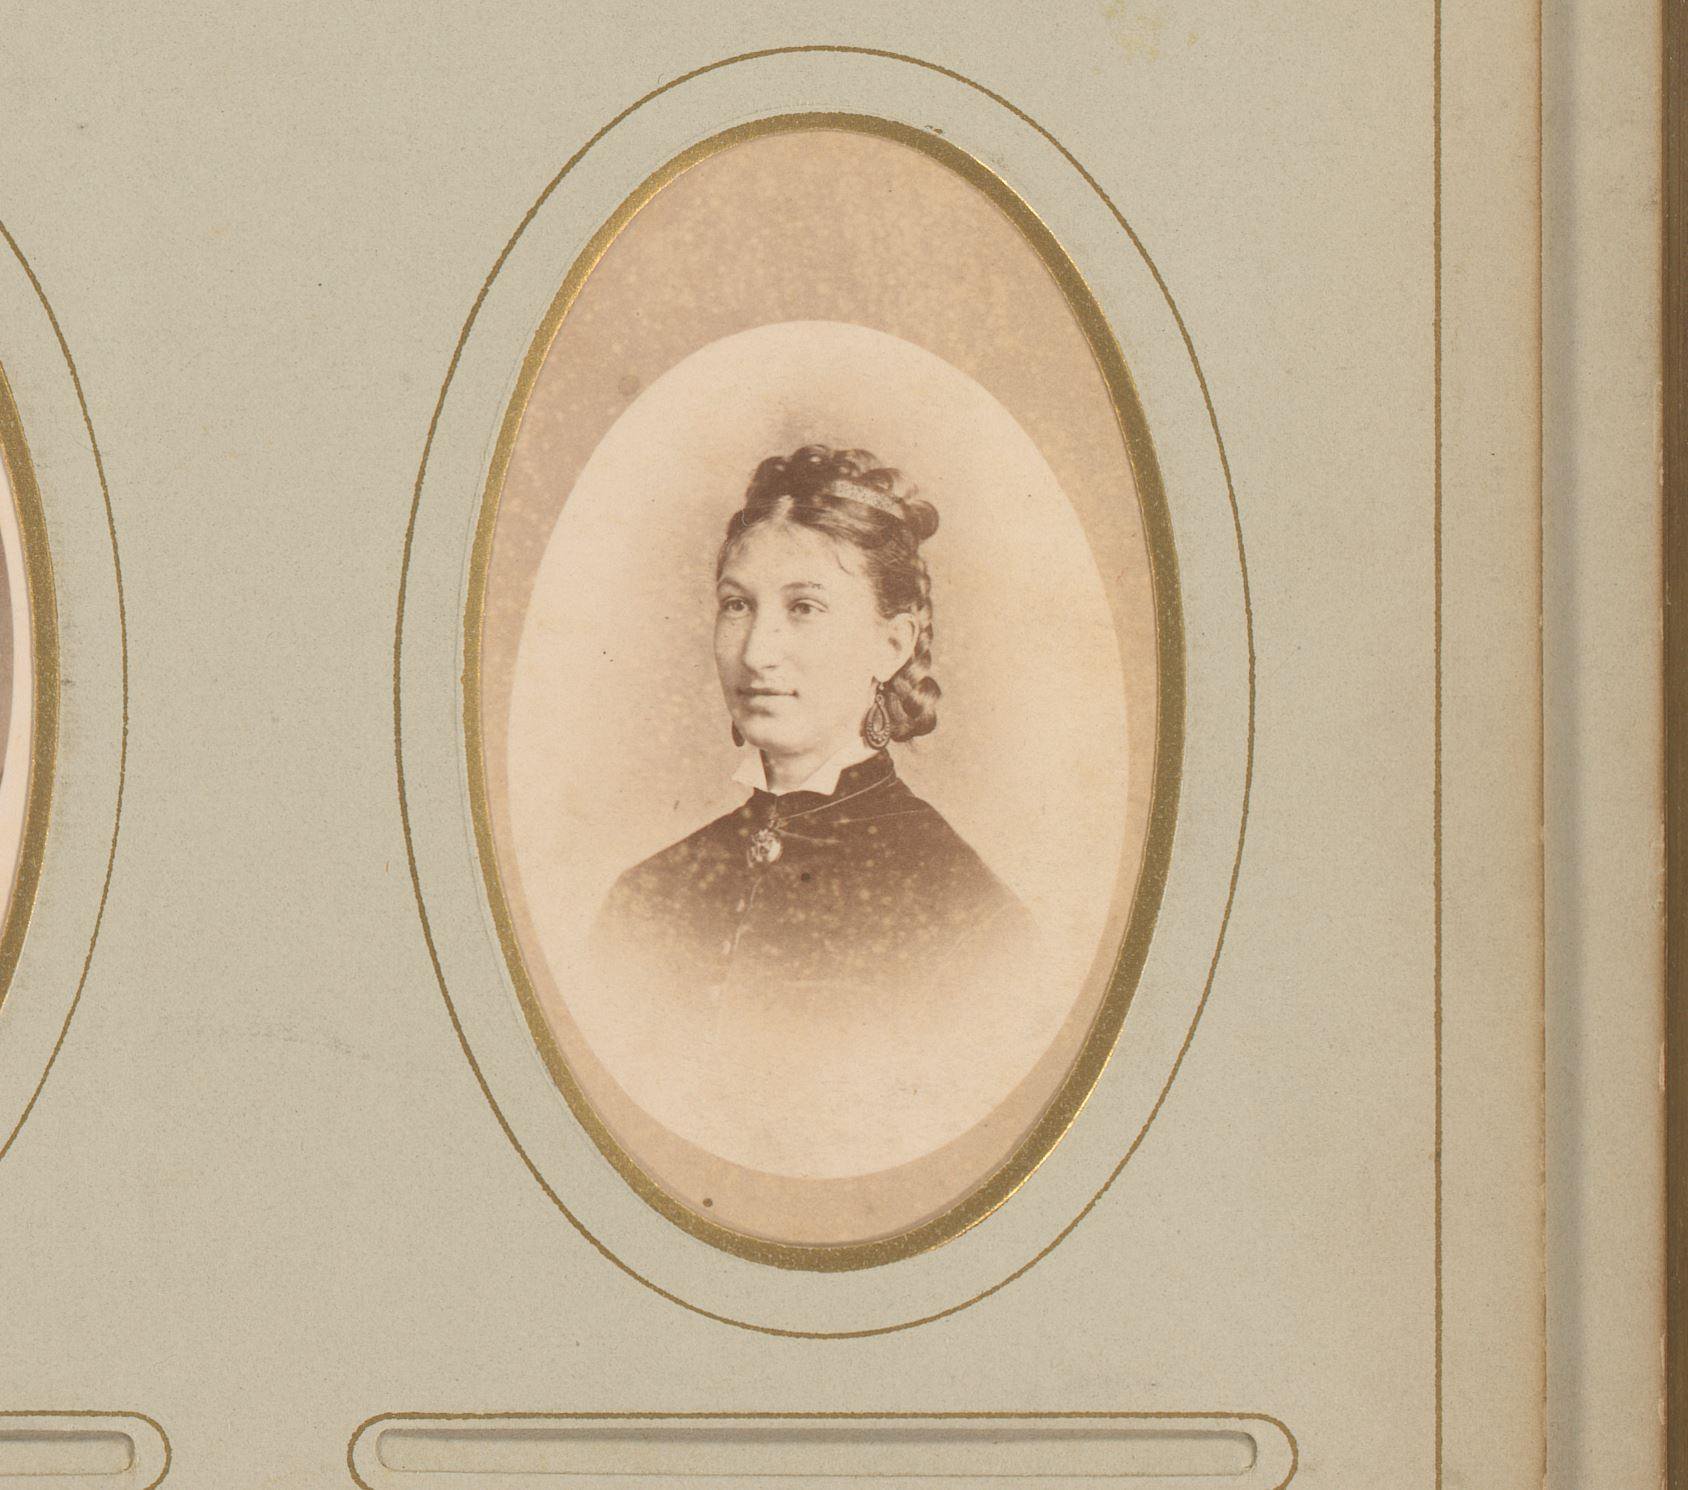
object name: carte de visite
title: Portret van een vrouw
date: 1874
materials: cardboard, photographic support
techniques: albumen print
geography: leuven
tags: historical persons - bb - woman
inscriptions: annotation: ‘7 [...] 1874.’, inscription: ‘PHOTOGRAPHIE/ DE/ Chs. Verbeke Schodts/ 20, Rue de Bruxelles/ LOUVAIN/ Le Cliché étant conservé, il suffit de/ rappeler e no pour obtenir des memes/ Cartes.’